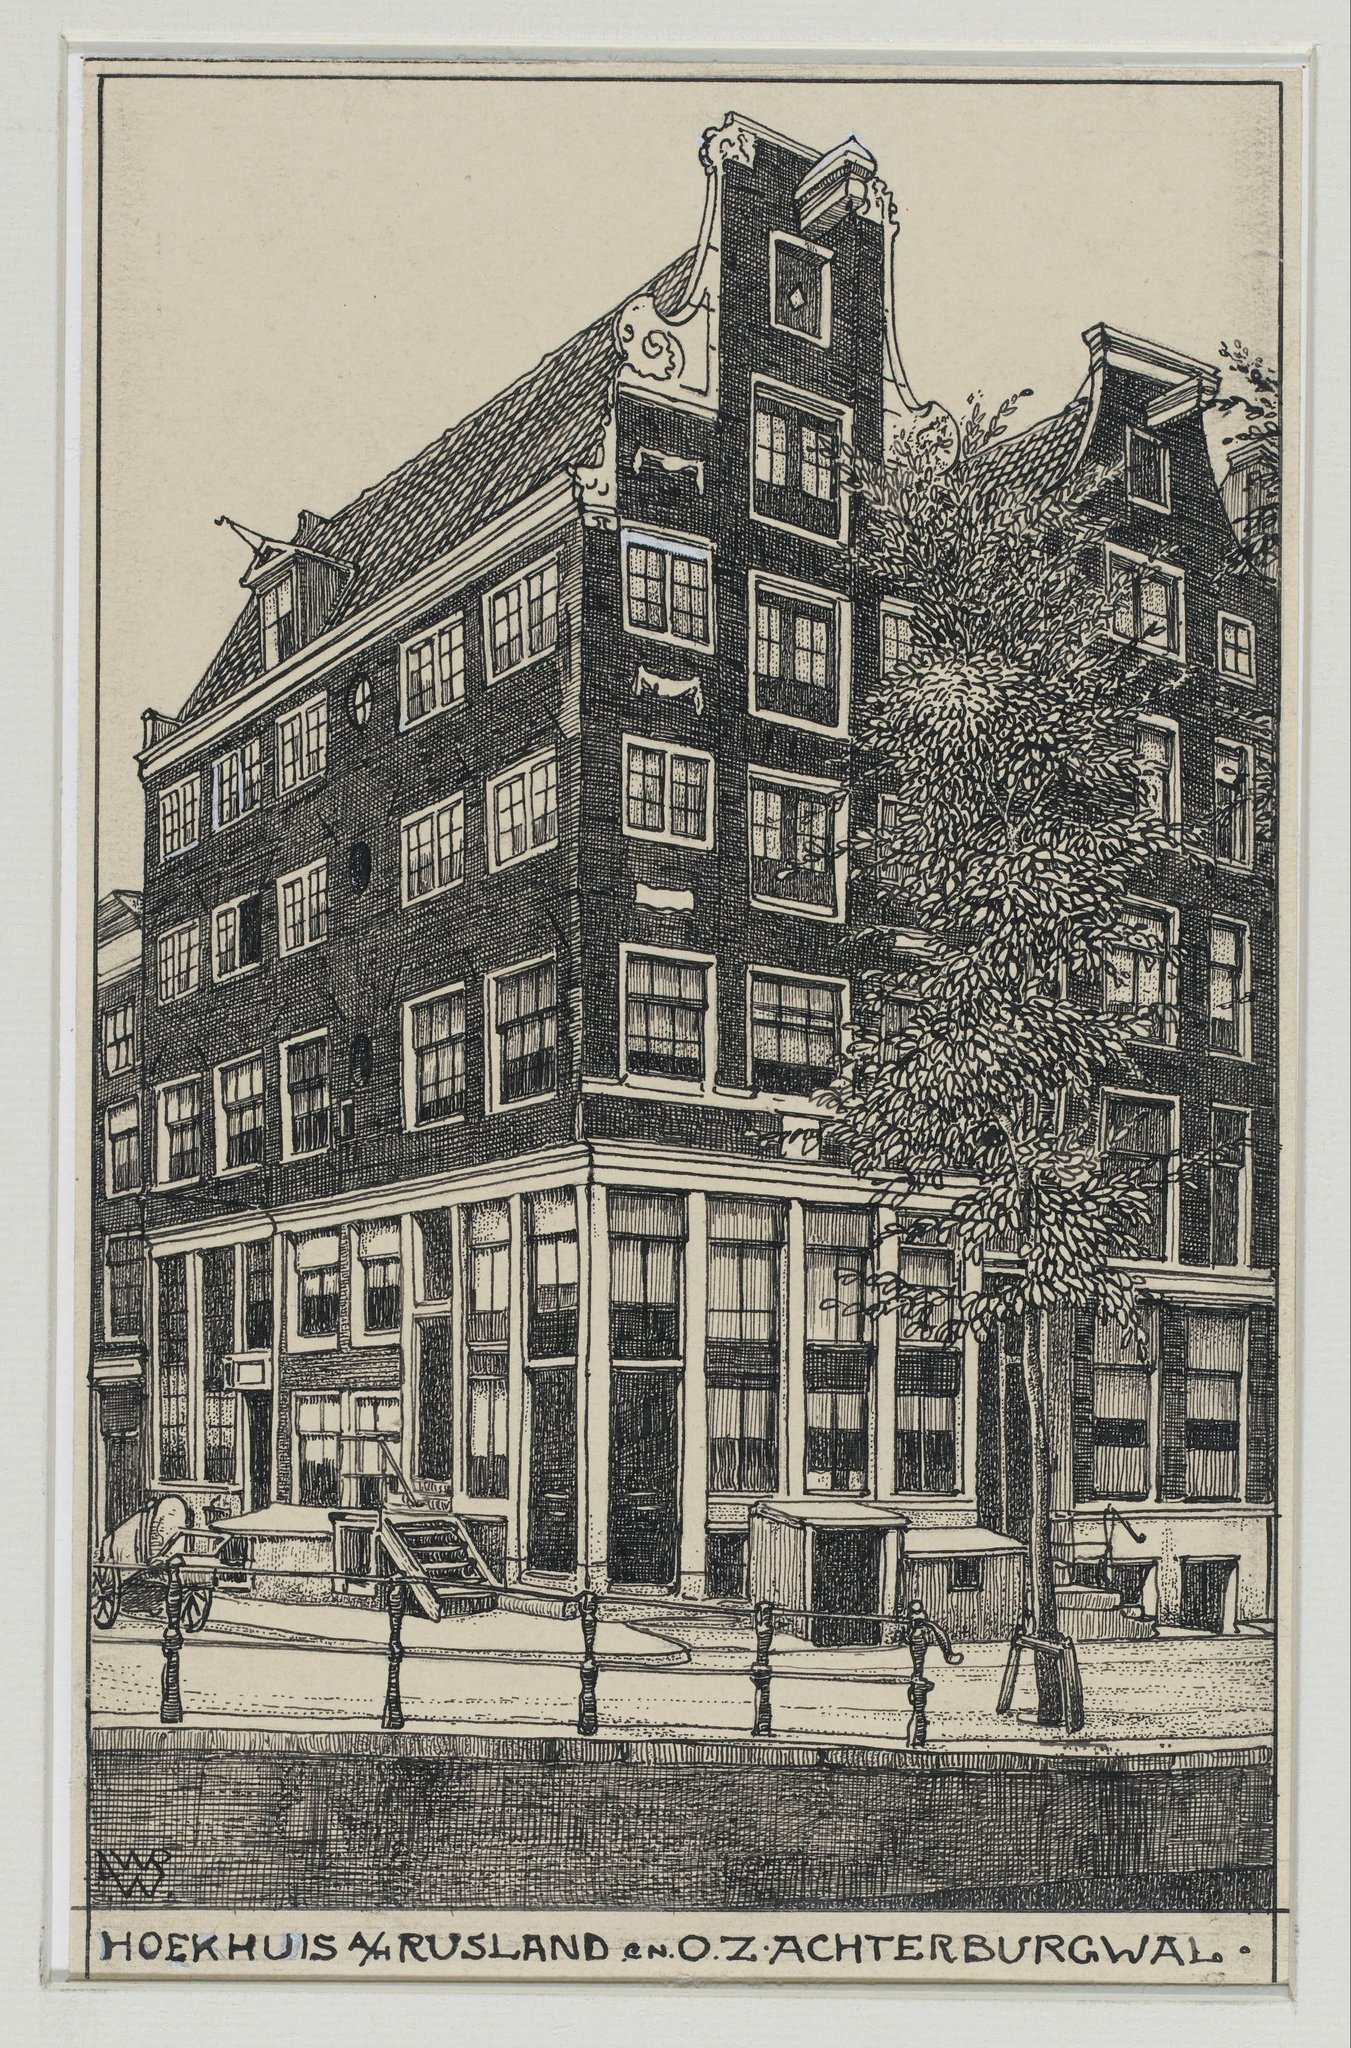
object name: drawing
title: Hoekhuis aan het Rusland en Oudezijds Achterburgwal te Amsterdam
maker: willem wenckebach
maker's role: designer, draughtsman, painter, print maker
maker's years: 1860-1937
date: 1870-1926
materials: paint, ink, paper, pencil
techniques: pen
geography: amsterdam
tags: city-view in general; 'veduta'